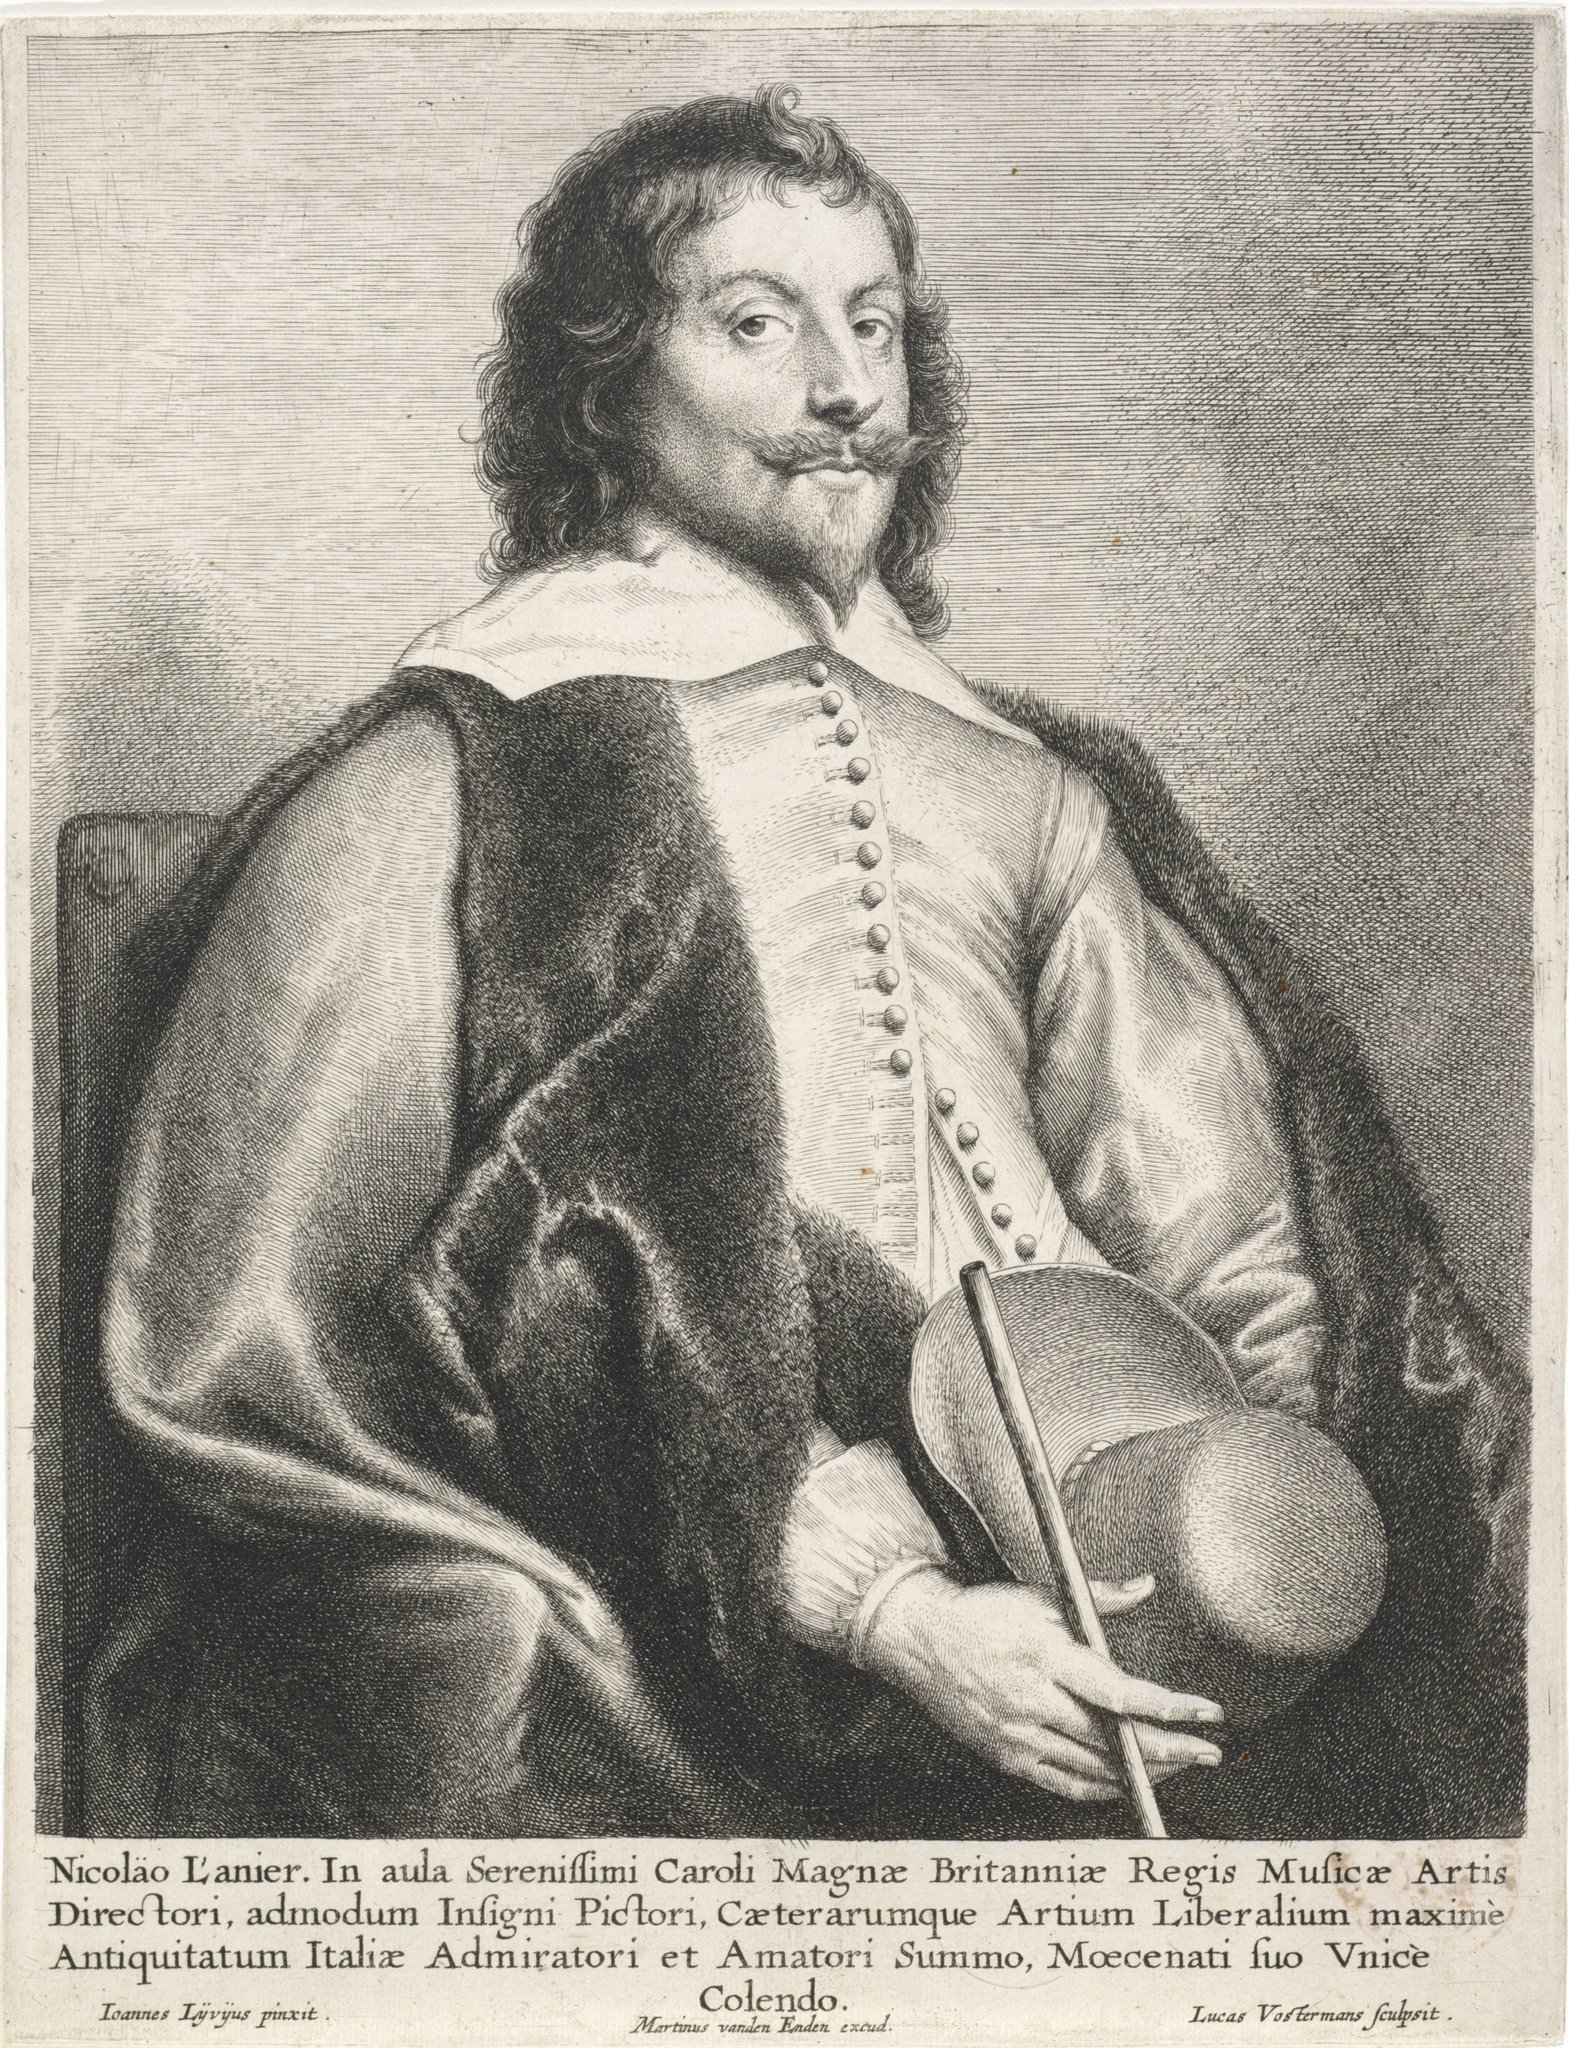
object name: print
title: Portret van Nicholas Lanier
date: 1630-1674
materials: paper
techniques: engraving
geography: antwerp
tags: nicholas lanier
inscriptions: collector's mark: Lugt 240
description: Portret van de Engelse componist en kunstenaar Nicholas Lanier.